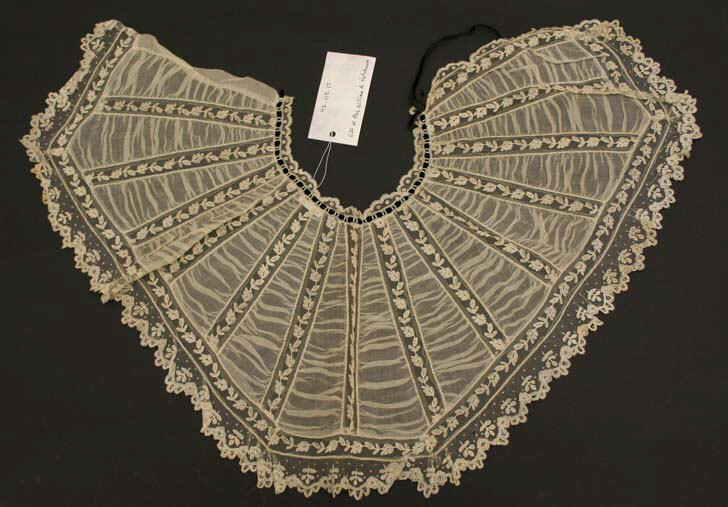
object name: collar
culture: american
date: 1700-1942